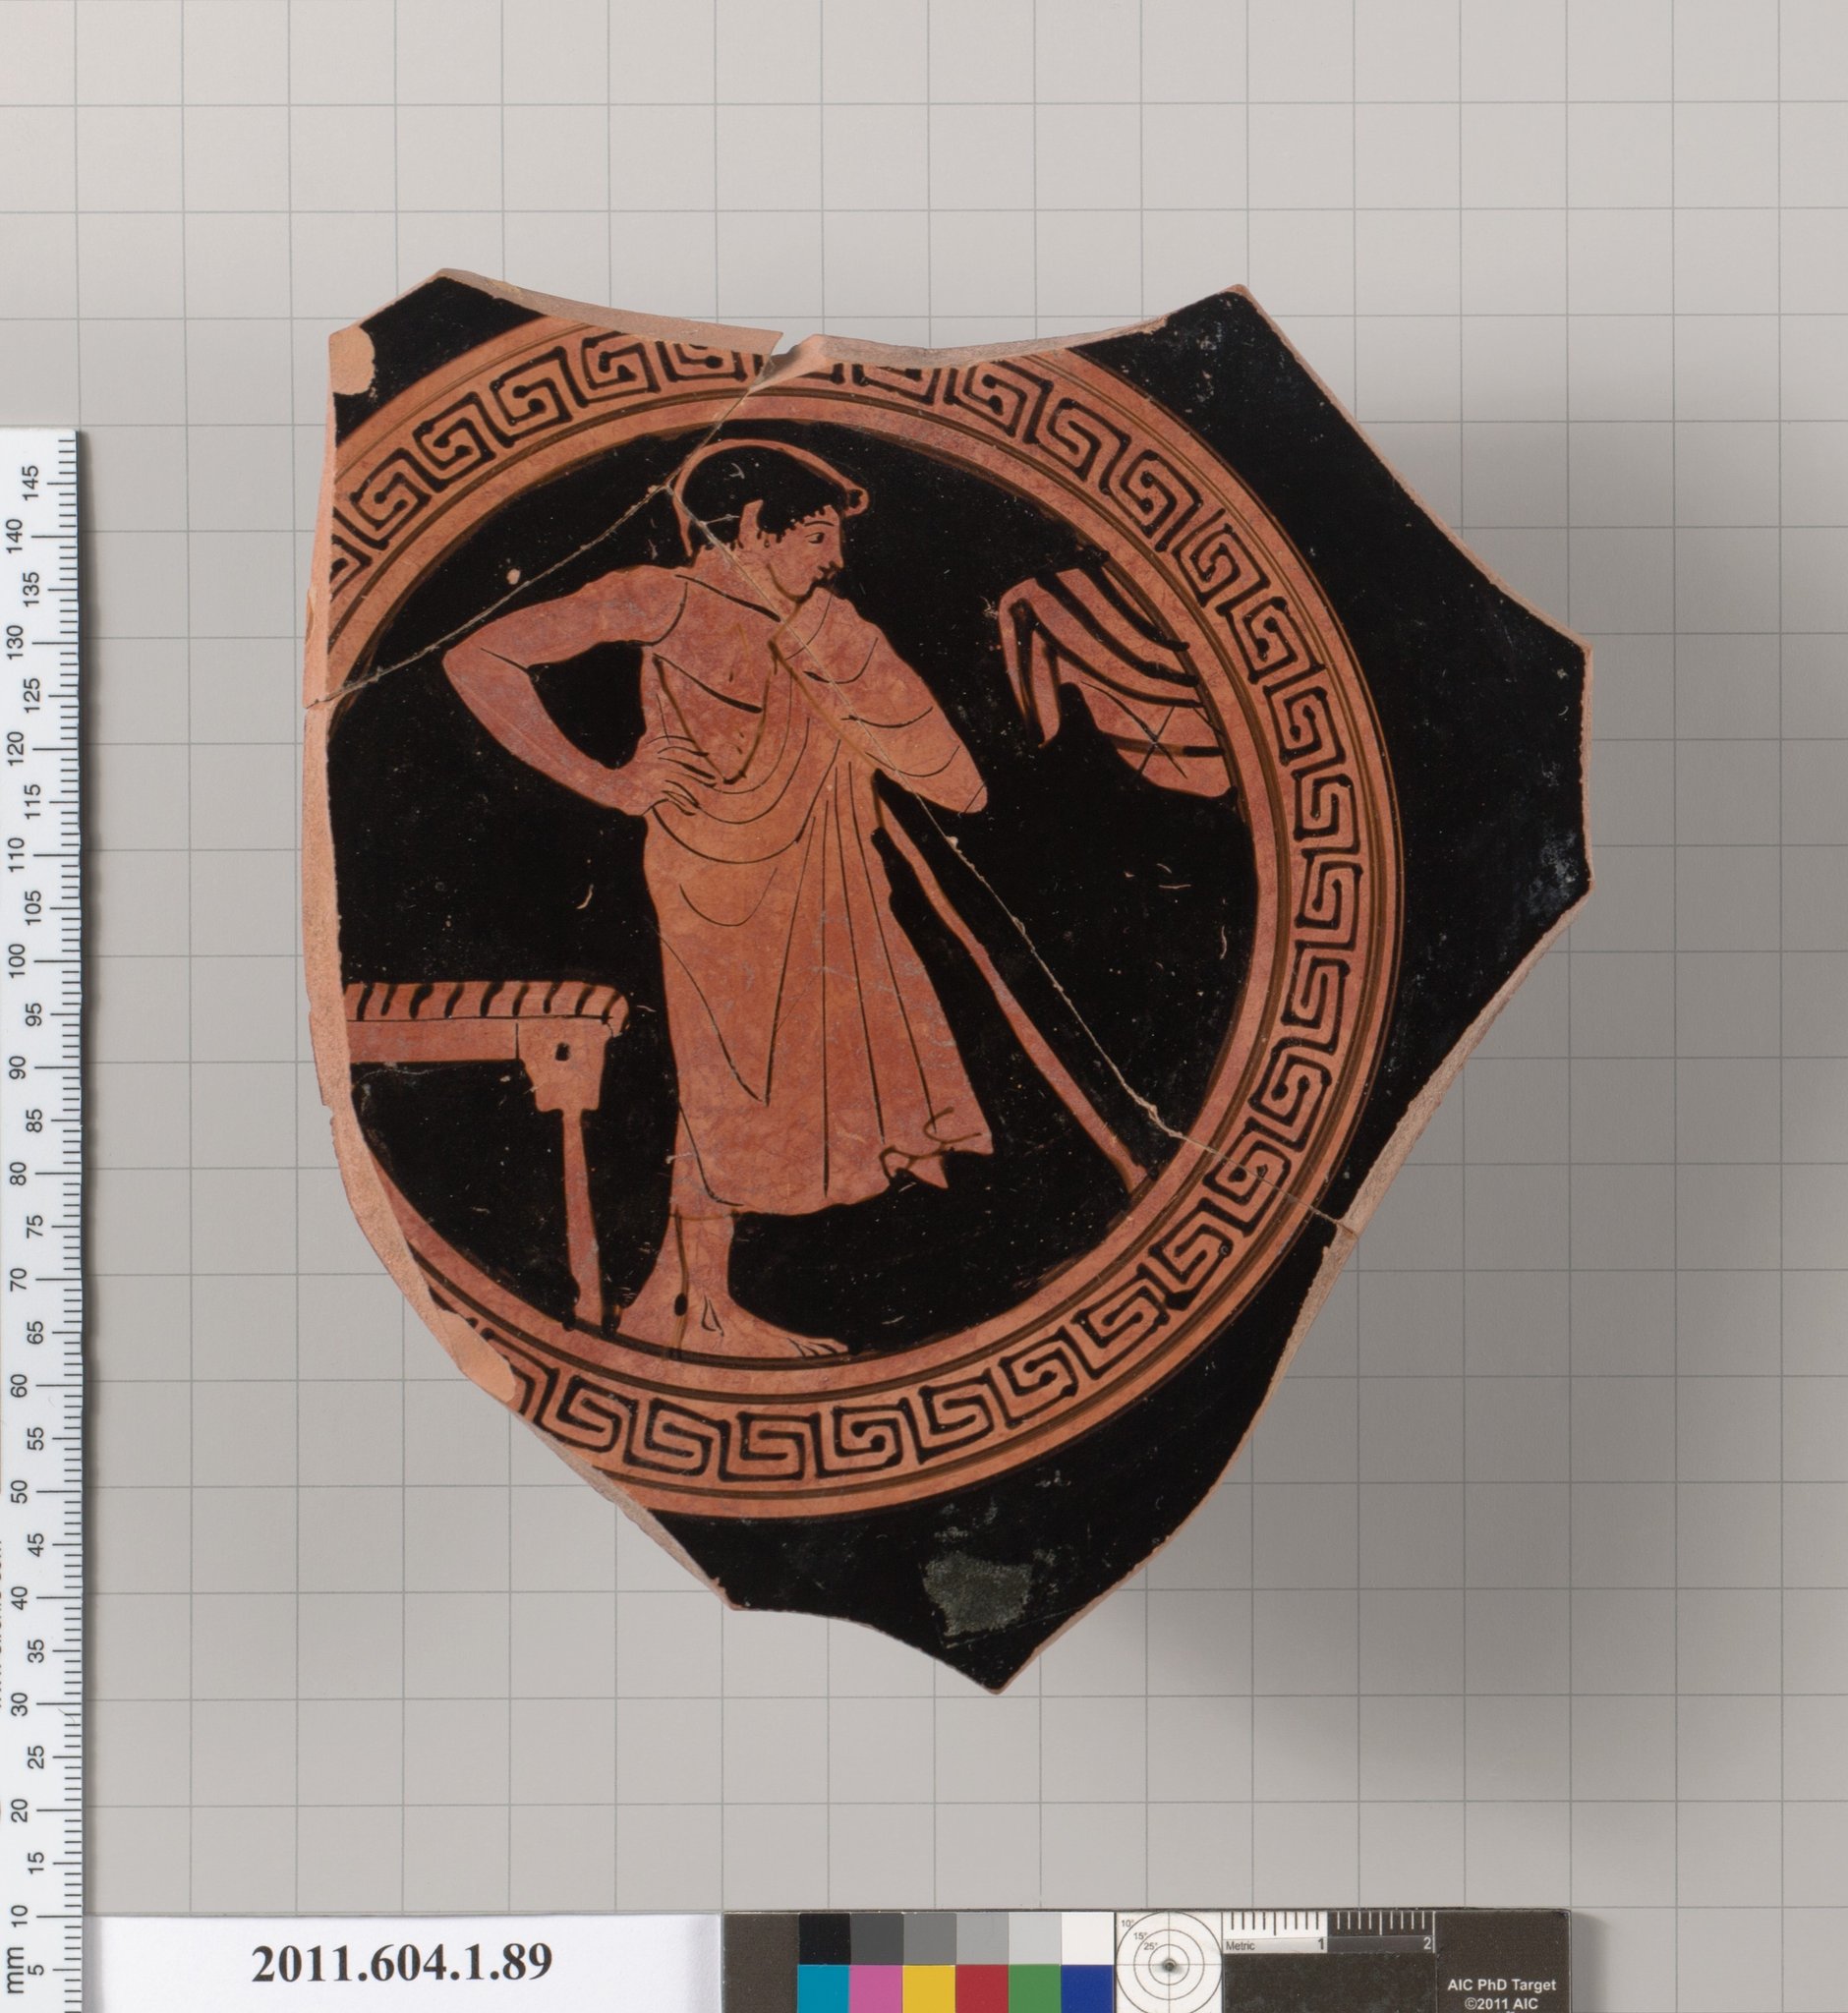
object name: kylix fragment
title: Terracotta fragment of a kylix (drinking cup)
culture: greek, attic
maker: painter of london d 12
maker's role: artist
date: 475-451 BCE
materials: terracotta